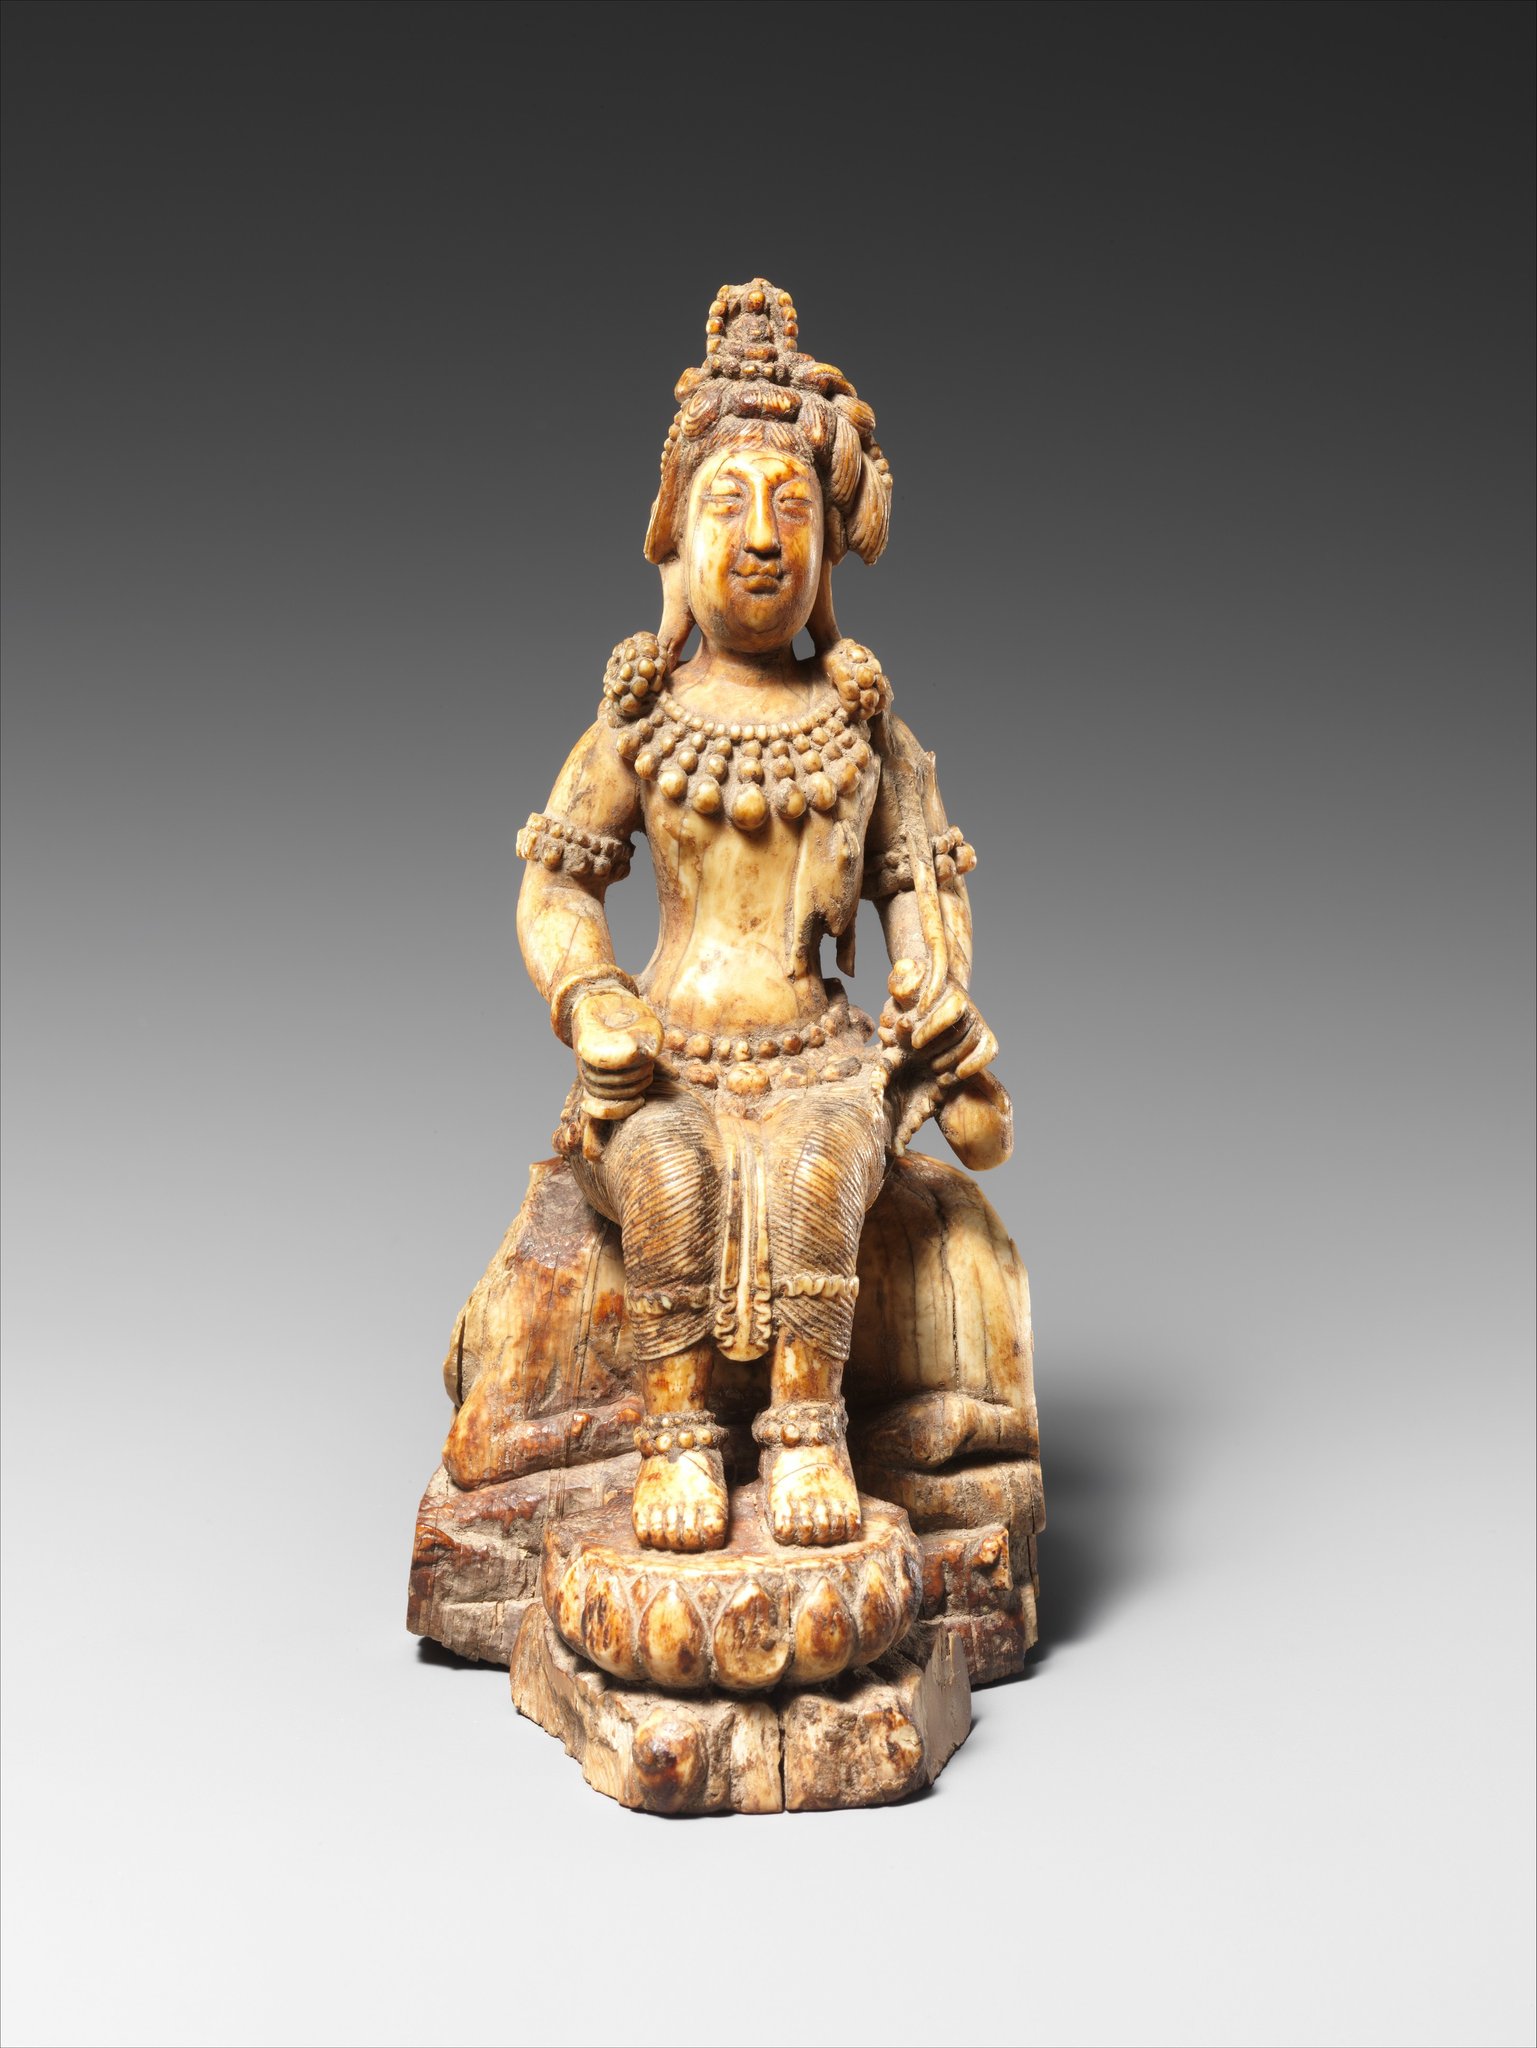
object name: figure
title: Avalokiteshvara, the Bodhisattva of Infinite Compassion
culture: tibetan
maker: choying dorje (the tenth karmapa)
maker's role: artist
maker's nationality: tibetan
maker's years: 1604-1674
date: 1601-1700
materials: ivory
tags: buddhism,avalokiteshvara,bodhisattvas